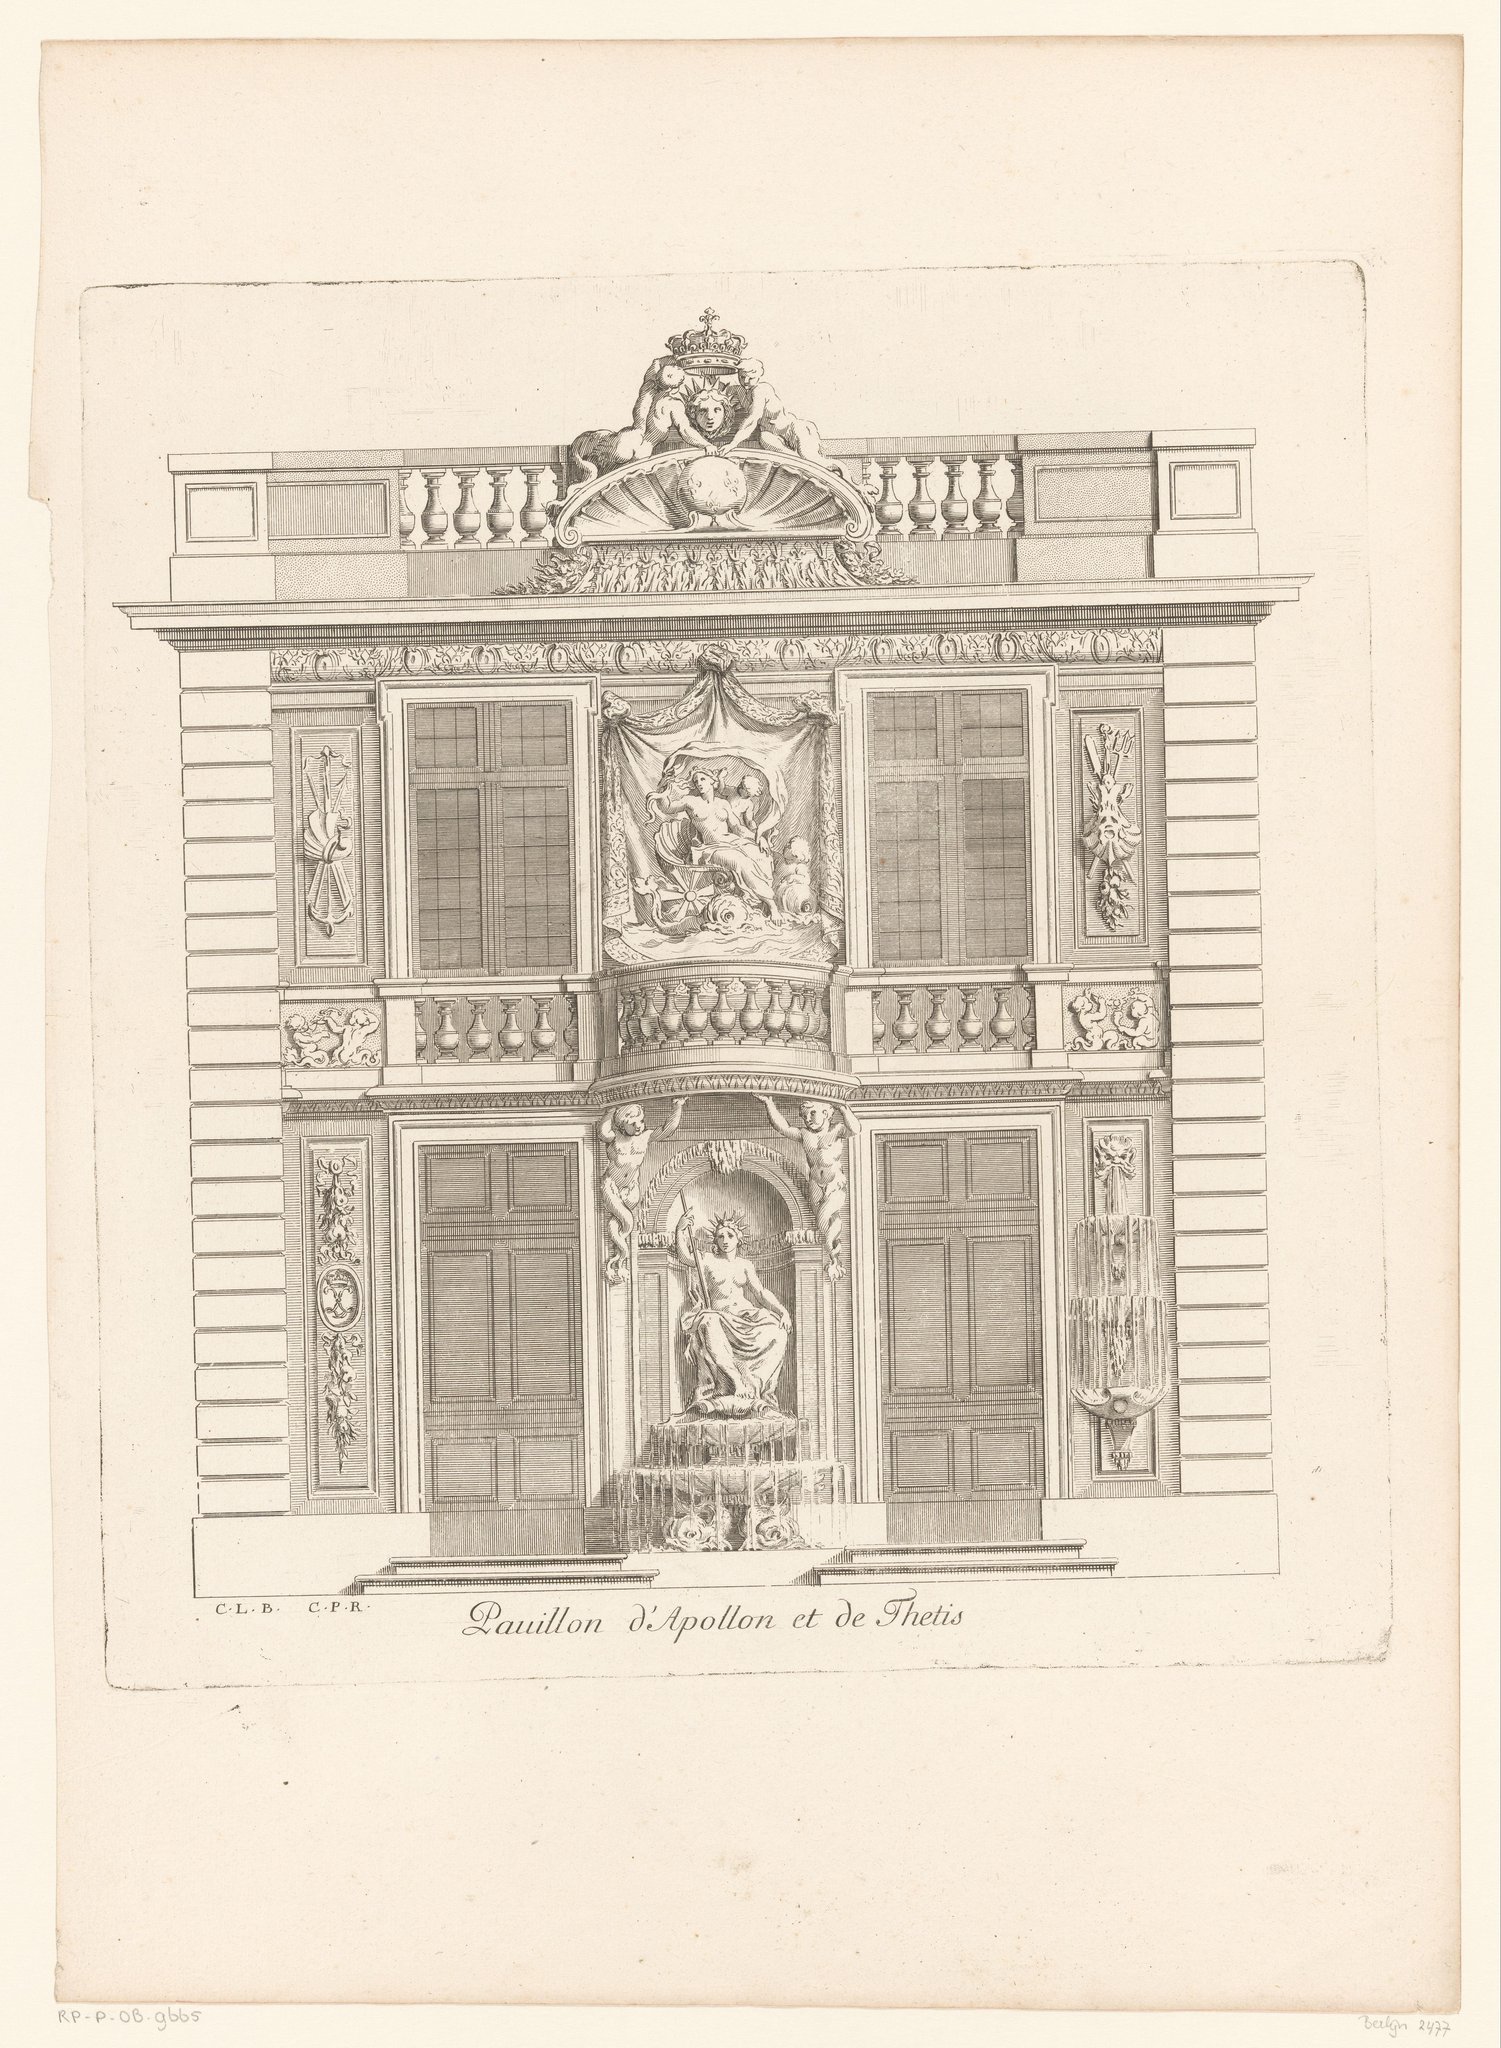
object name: ornament print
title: Pavillon d'Apollon et de Thetis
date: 1672-1686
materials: paper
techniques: etching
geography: paris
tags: (story of) apollo (phoebus), (story of) thetis; 'thethi, ninfa del mare' (ripa), façade (of house or building)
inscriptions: collector's mark: Lugt 2228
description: Façade van een paviljoen met trofeeën, fonteinen, balkons, Thetis in een strijdwapen, Apollo op een troon in een nis en een balustrade aan de bovenzijde.